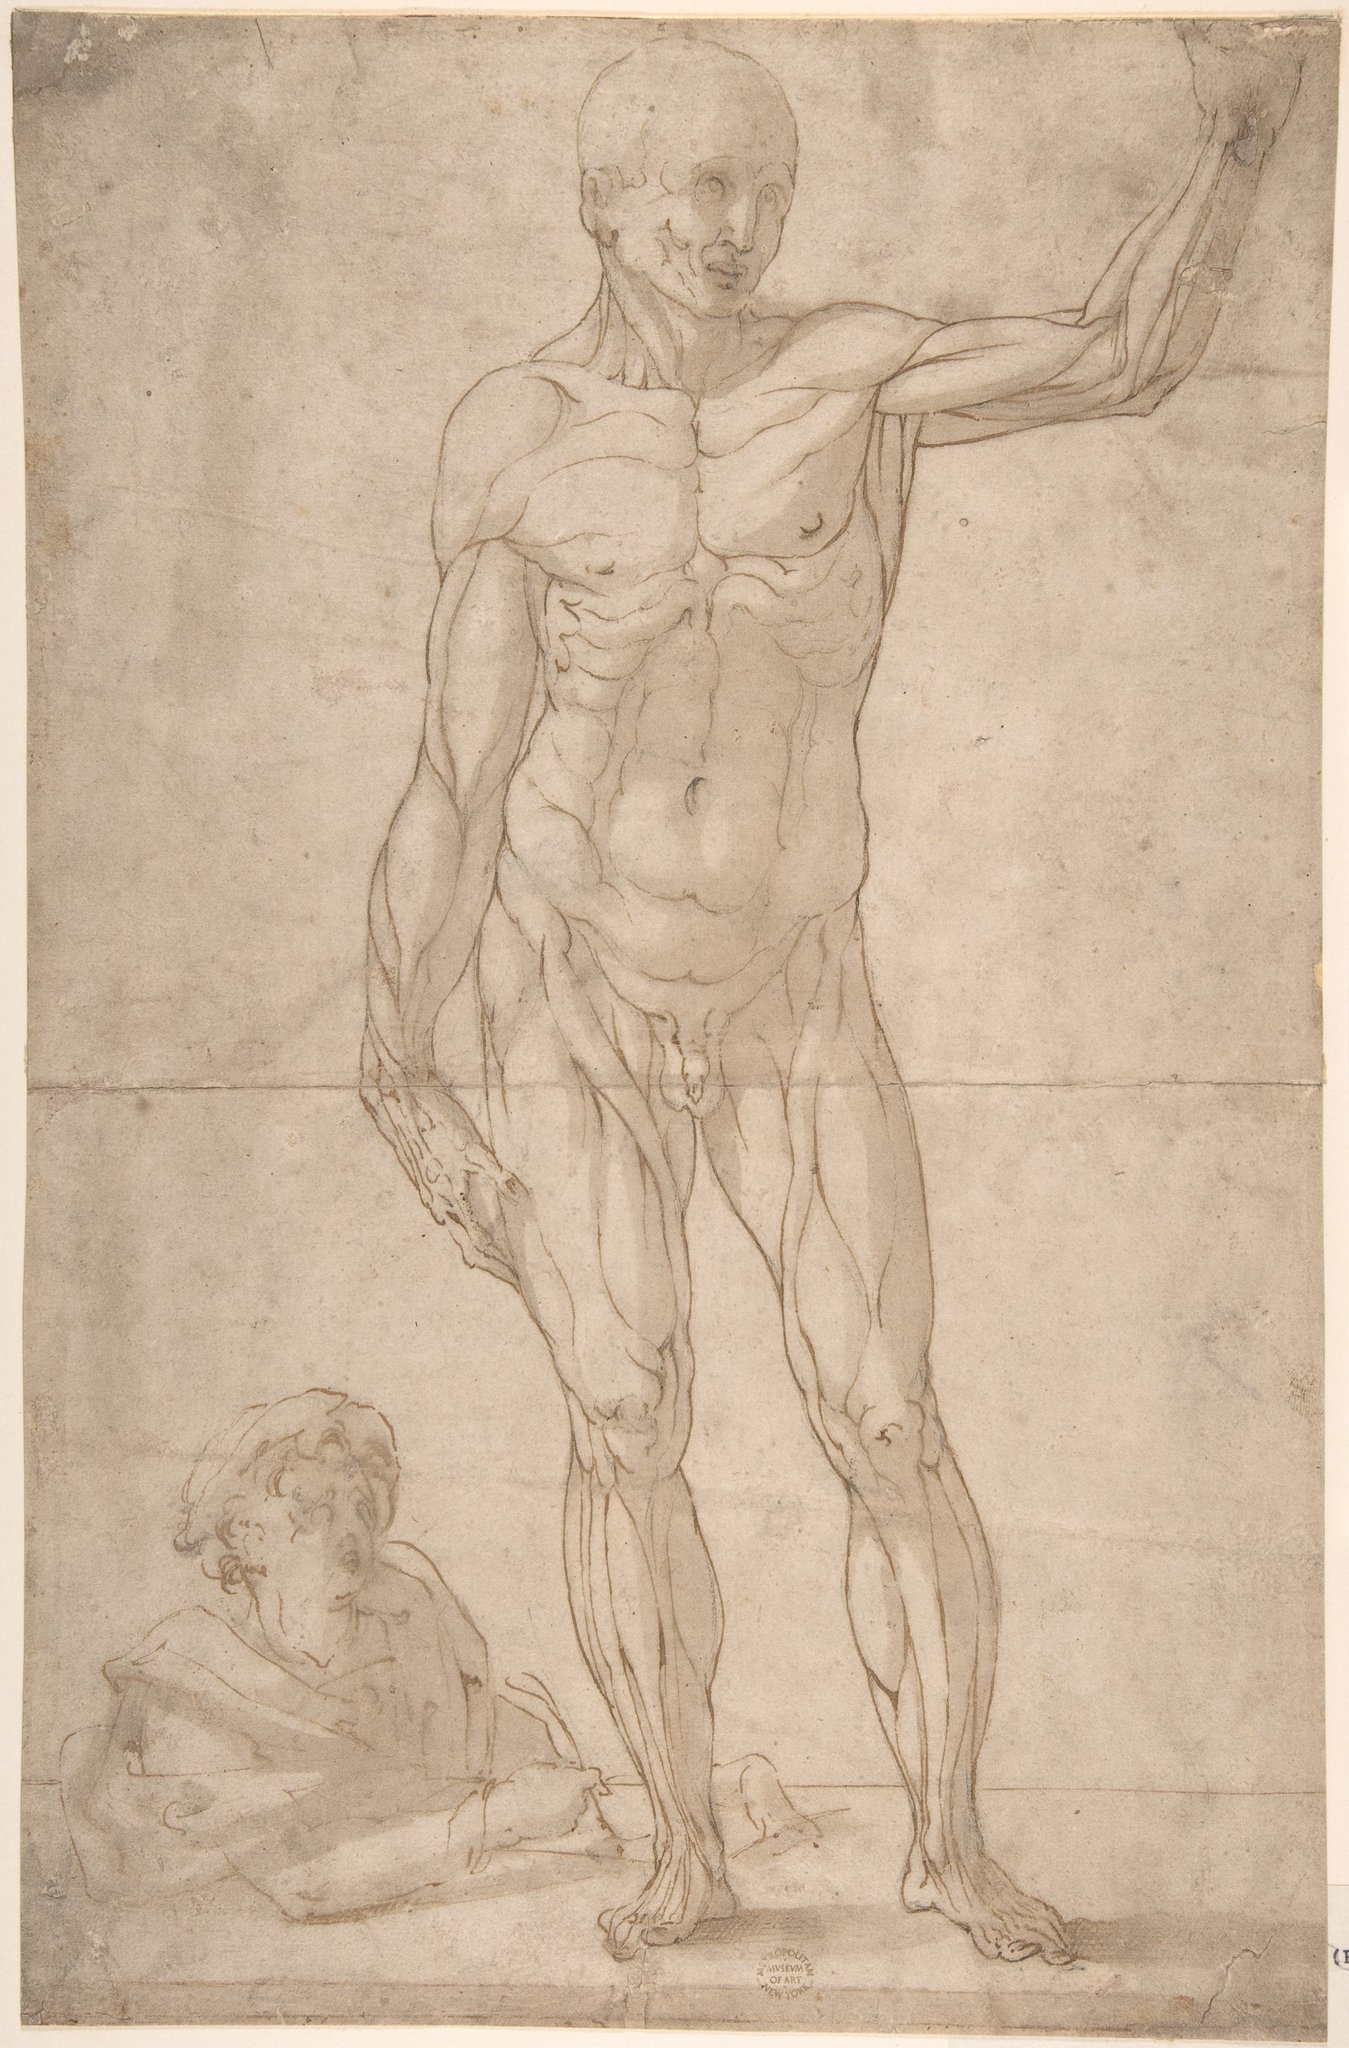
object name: drawing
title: Study of Anatomy (A Youth Drawing an Ecorché of a Standing Man)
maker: anonymous, italian, 16th to early 17th century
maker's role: artist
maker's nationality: italian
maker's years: 1500-1640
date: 1550-1600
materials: chalk, ink, drawing material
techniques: brush, pen, wash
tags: male nudes